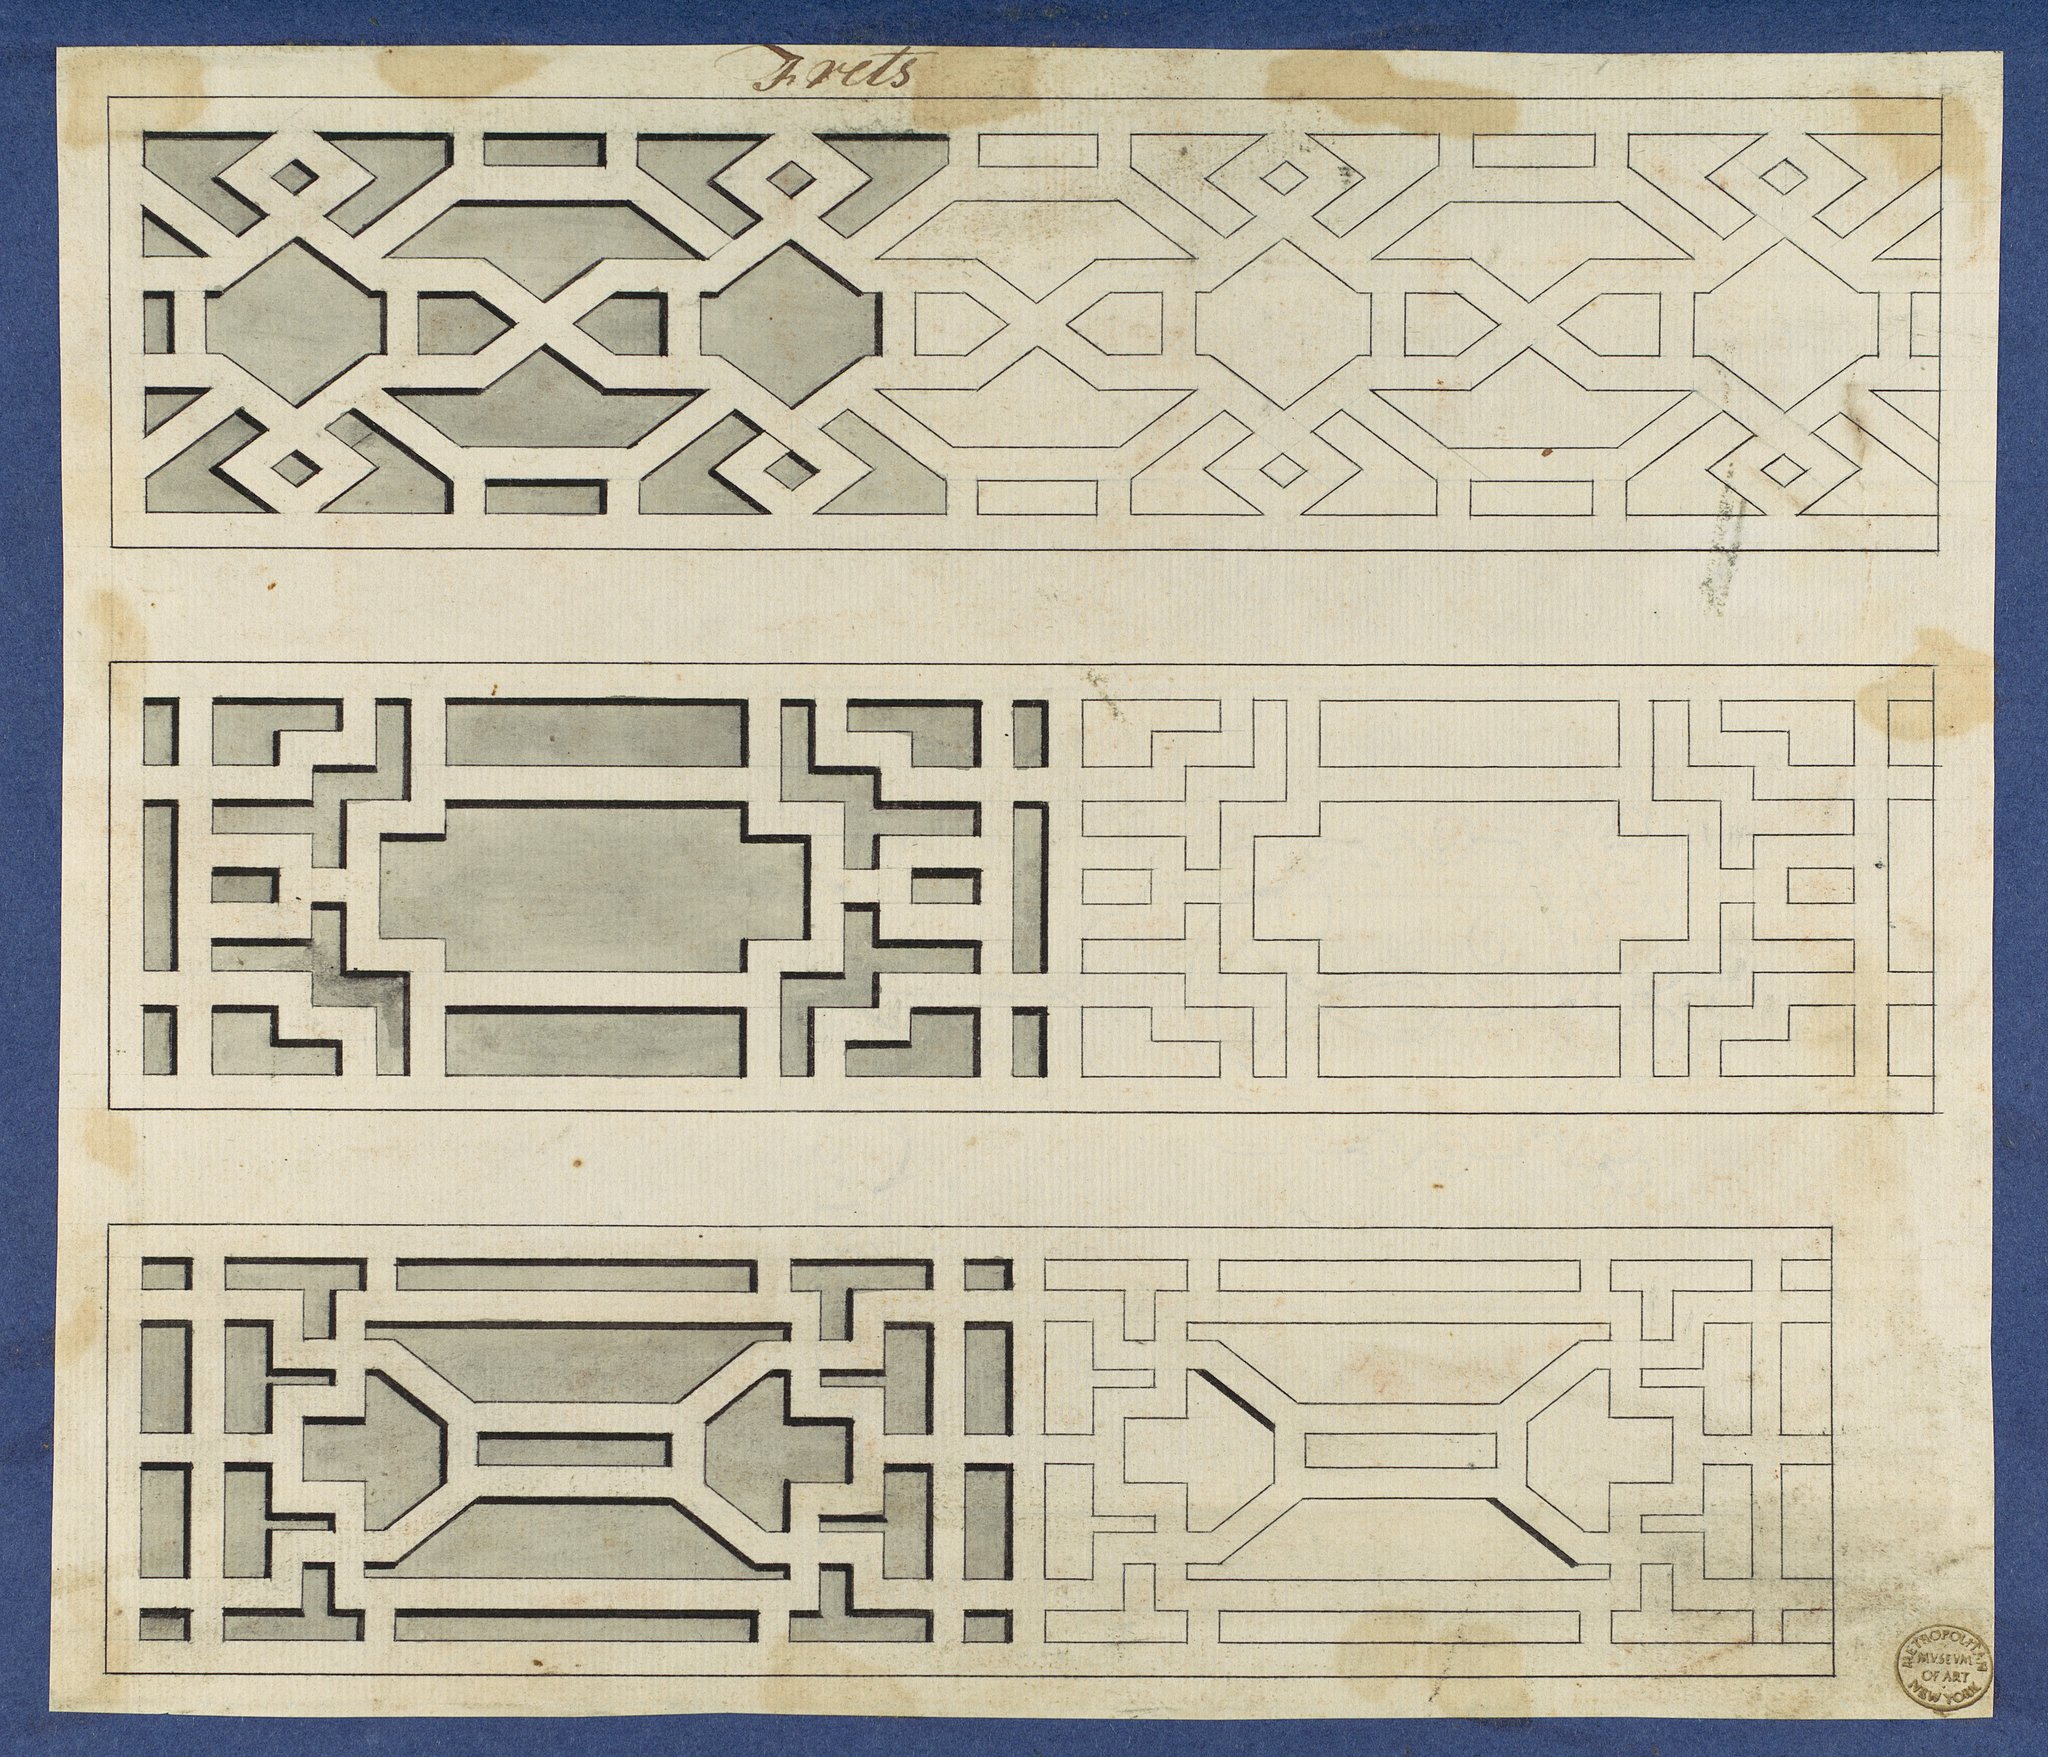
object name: drawing ornament architecture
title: Frets, from Chippendale Drawings, Vol. II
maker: thomas chippendale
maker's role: artist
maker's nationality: british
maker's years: 1718-1779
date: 1754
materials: ink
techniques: wash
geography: london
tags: ornament